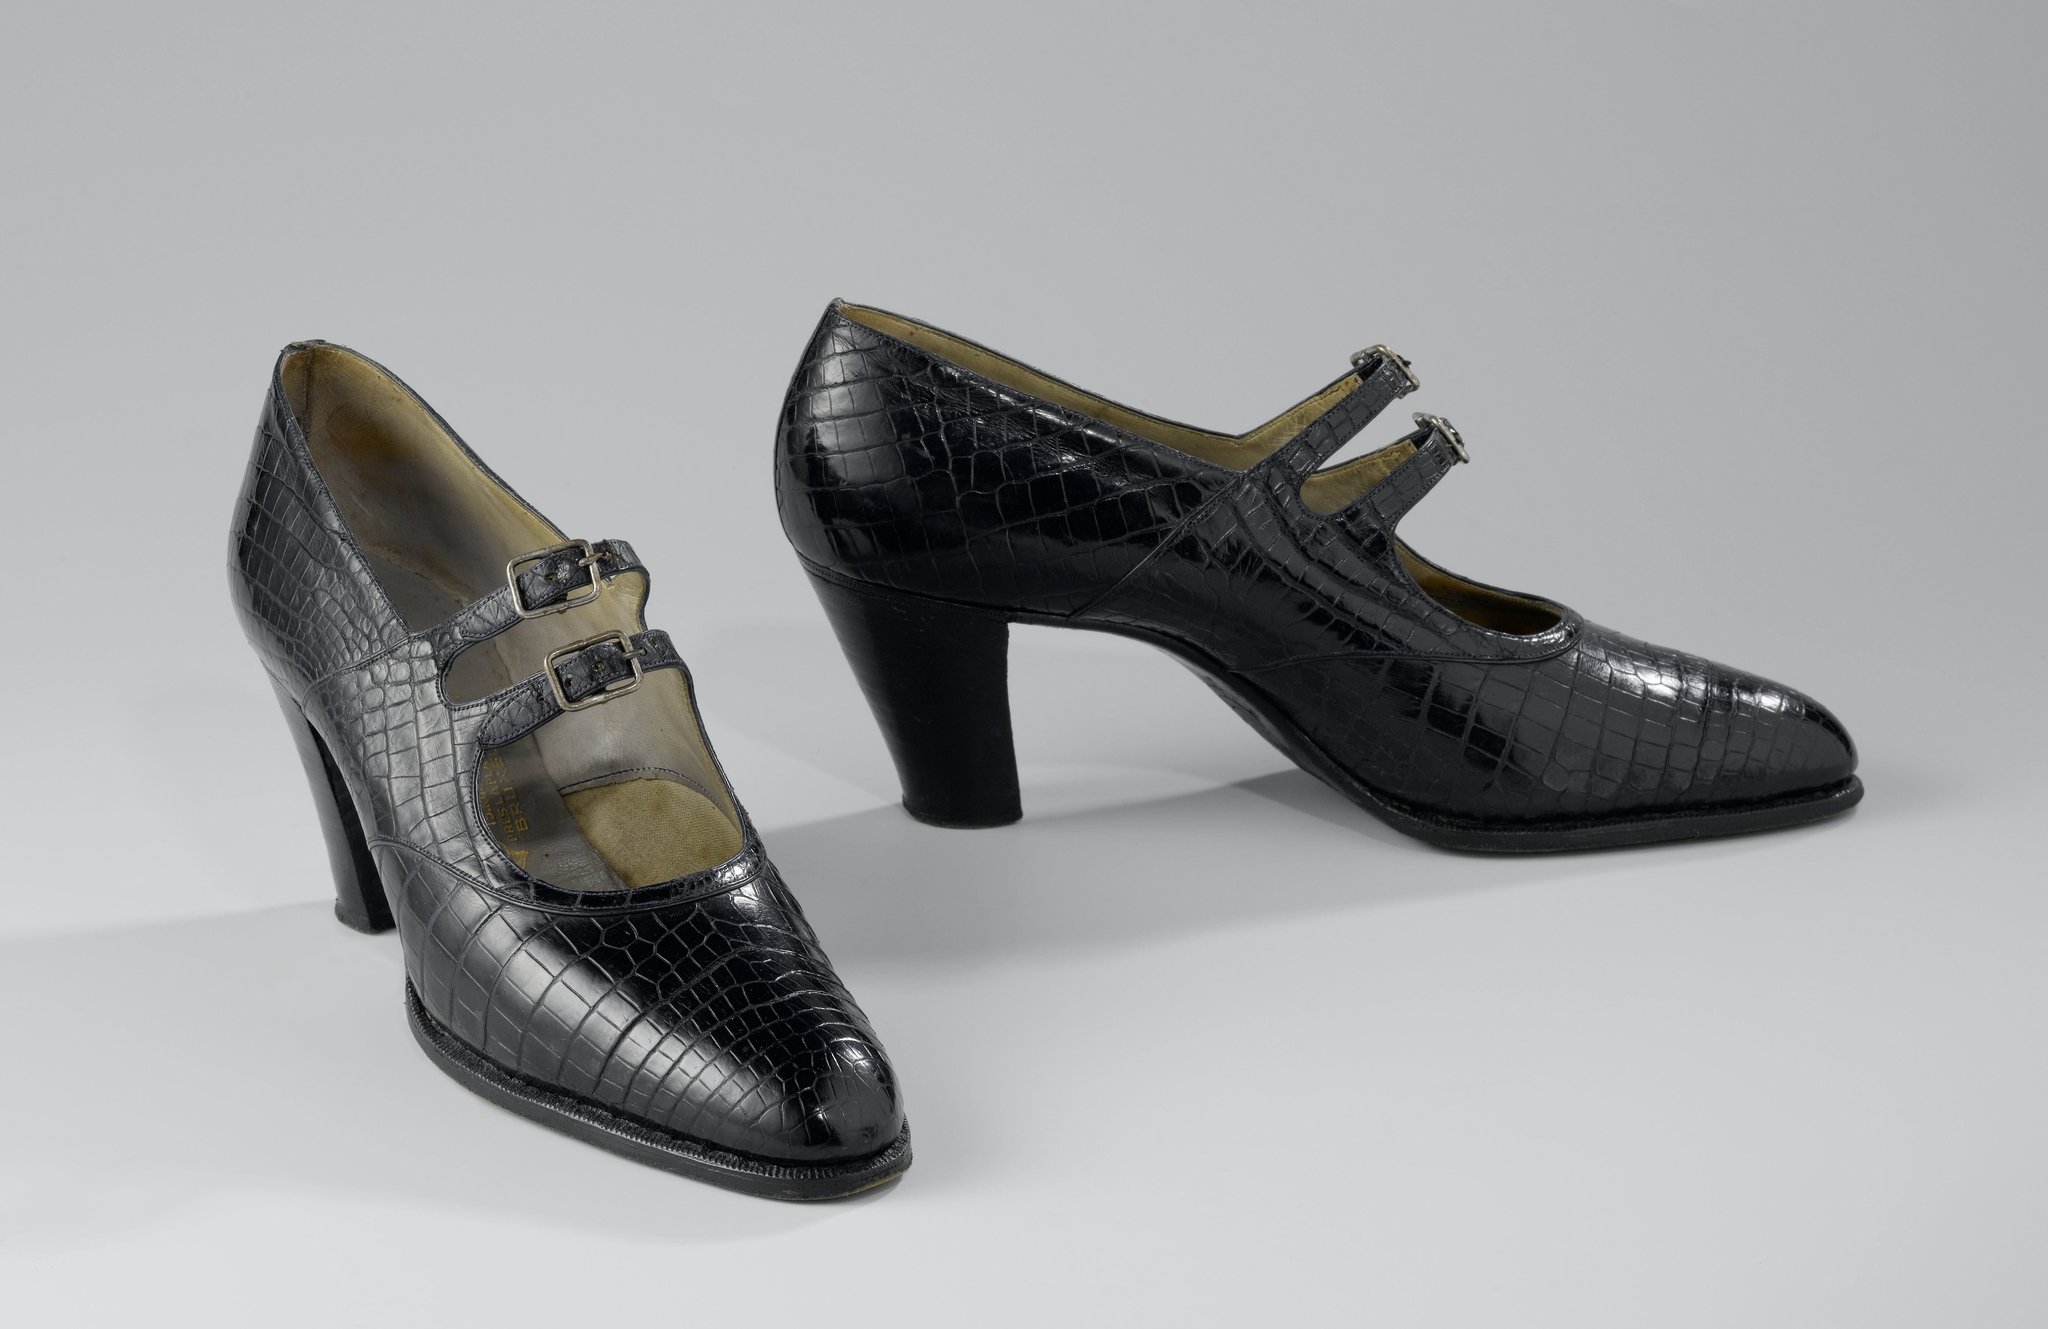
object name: womenswear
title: Pair of shoes with straps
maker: a. van goethem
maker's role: schoenmaker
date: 1939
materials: cotton, leather, metal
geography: brussels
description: Linkerbandschoen, van blauwzwart krokodillenleer met gespsluiting en hoge, onbeklede hak. Model: de schoen is opgebouwd uit een voorblad, twee zijpanden met twee riemen en metalen gespen en twee hielpanden. De zijpanden vormen een smalle bies op de voorvoet. Sluiting midden op de wreef door middel van twee riemen met vierkante, metalen gespen. De achternaad wordt gecamoufleerd door een smalle bies. Hoge ( 7 cm) onbeklede hak. De voorvoet is gevoerd met naturelkleurig katoen; de rest met grijs leer. Binnenzool met gouden opdruk. Adres: (op binnenzool) A. VAN GOETHEM, 15 RUE DE NAMUR/PRES LA PLACE ROYALE, BRUXELLES. Opmerking: in de linkerschoen is met inkt geschreven: 113504/2391.